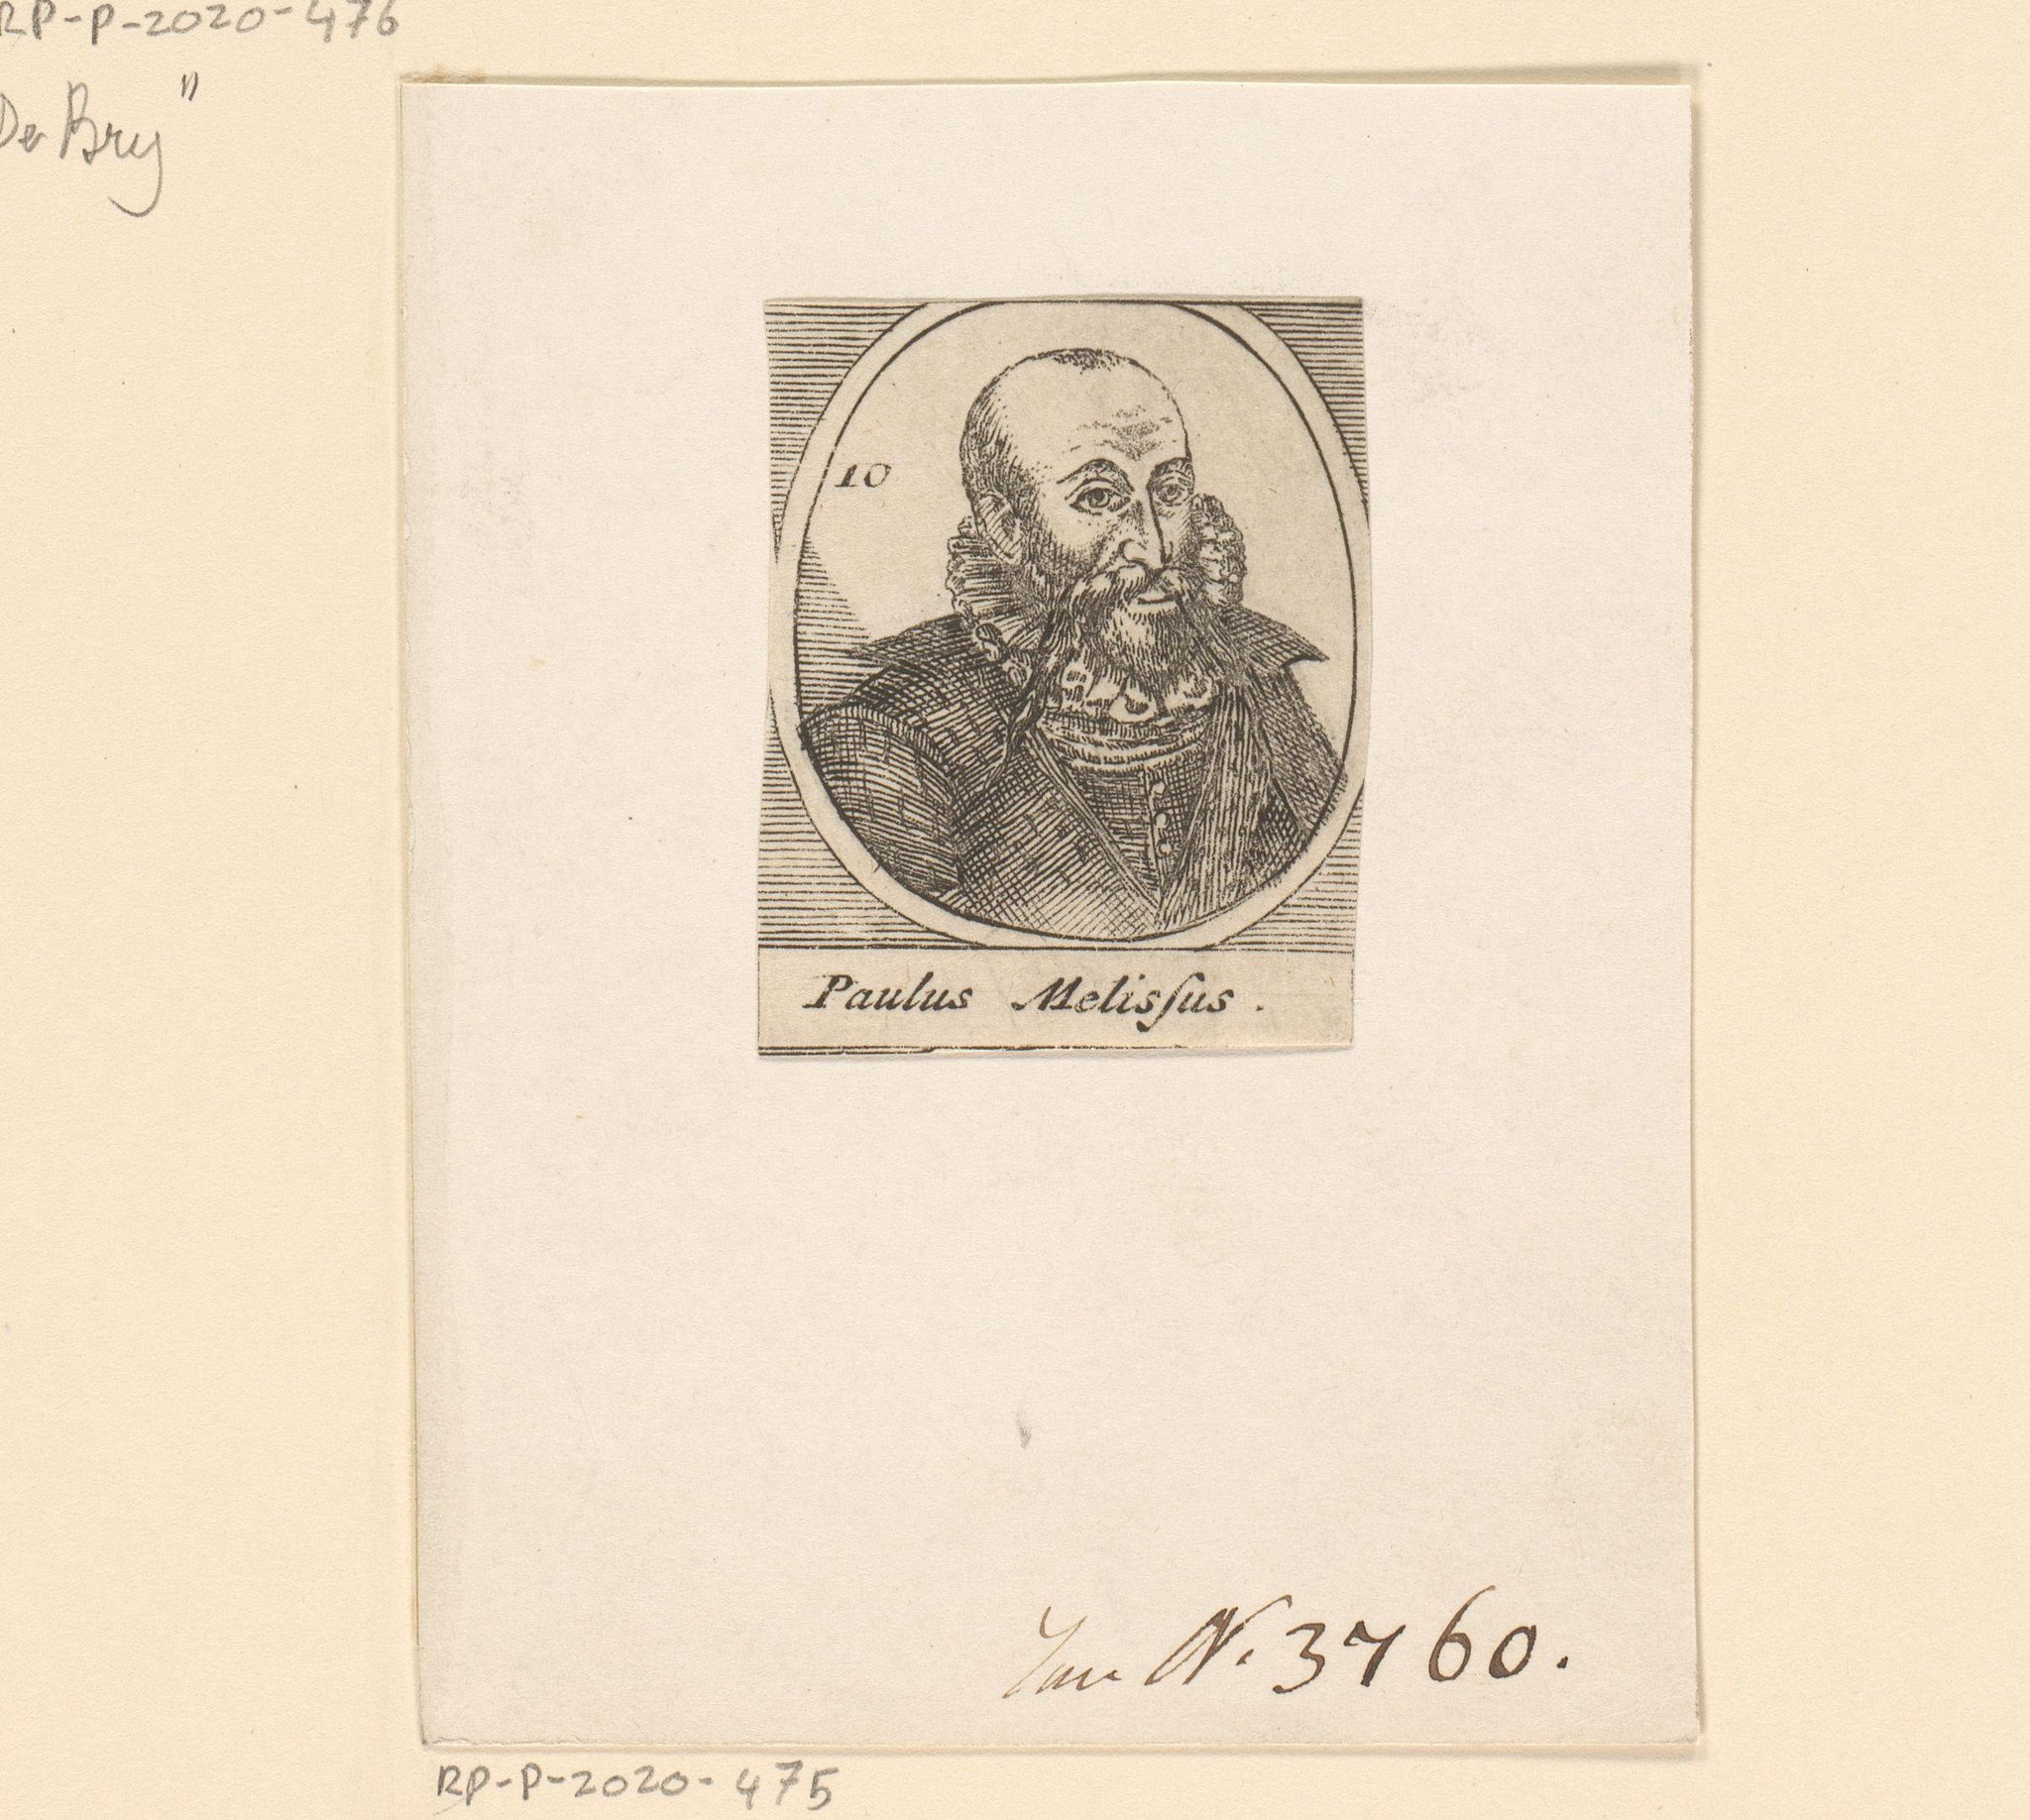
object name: print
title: Paulus Melissus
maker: Anonymous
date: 1600-1699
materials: paper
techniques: engraving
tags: paul schede, historical persons, portrait of a writer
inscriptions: inscription: ‘Inv N. 3760.’